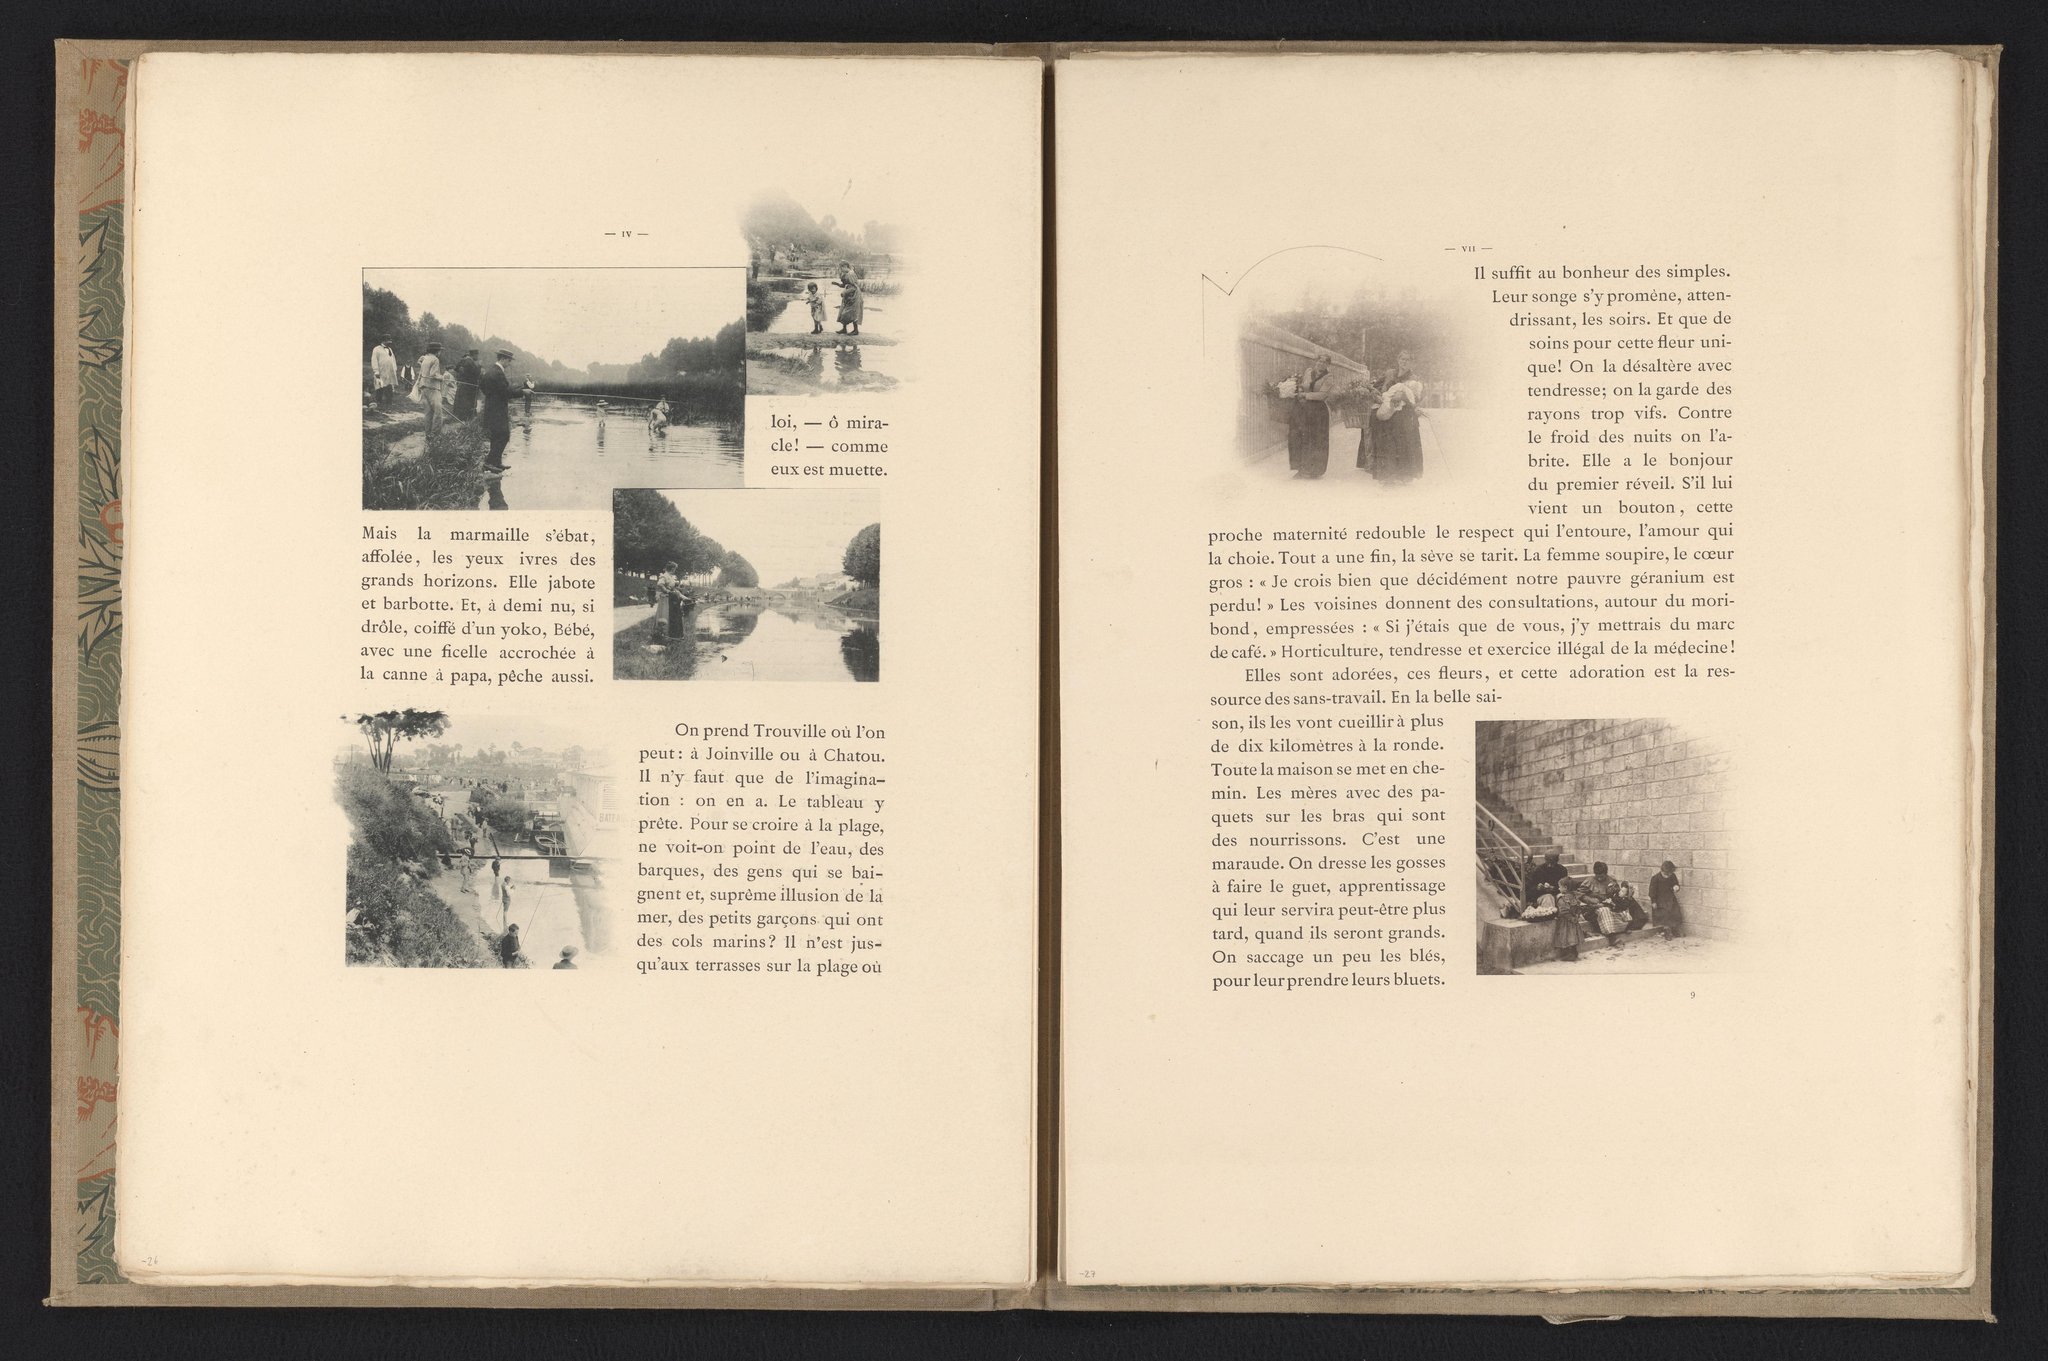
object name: photomechanical print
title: Á travers les rues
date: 1896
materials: paper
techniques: photograph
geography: paris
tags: flowers, street-trader, paris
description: Prenten op zevenenveertigste ongenummerde pagina.